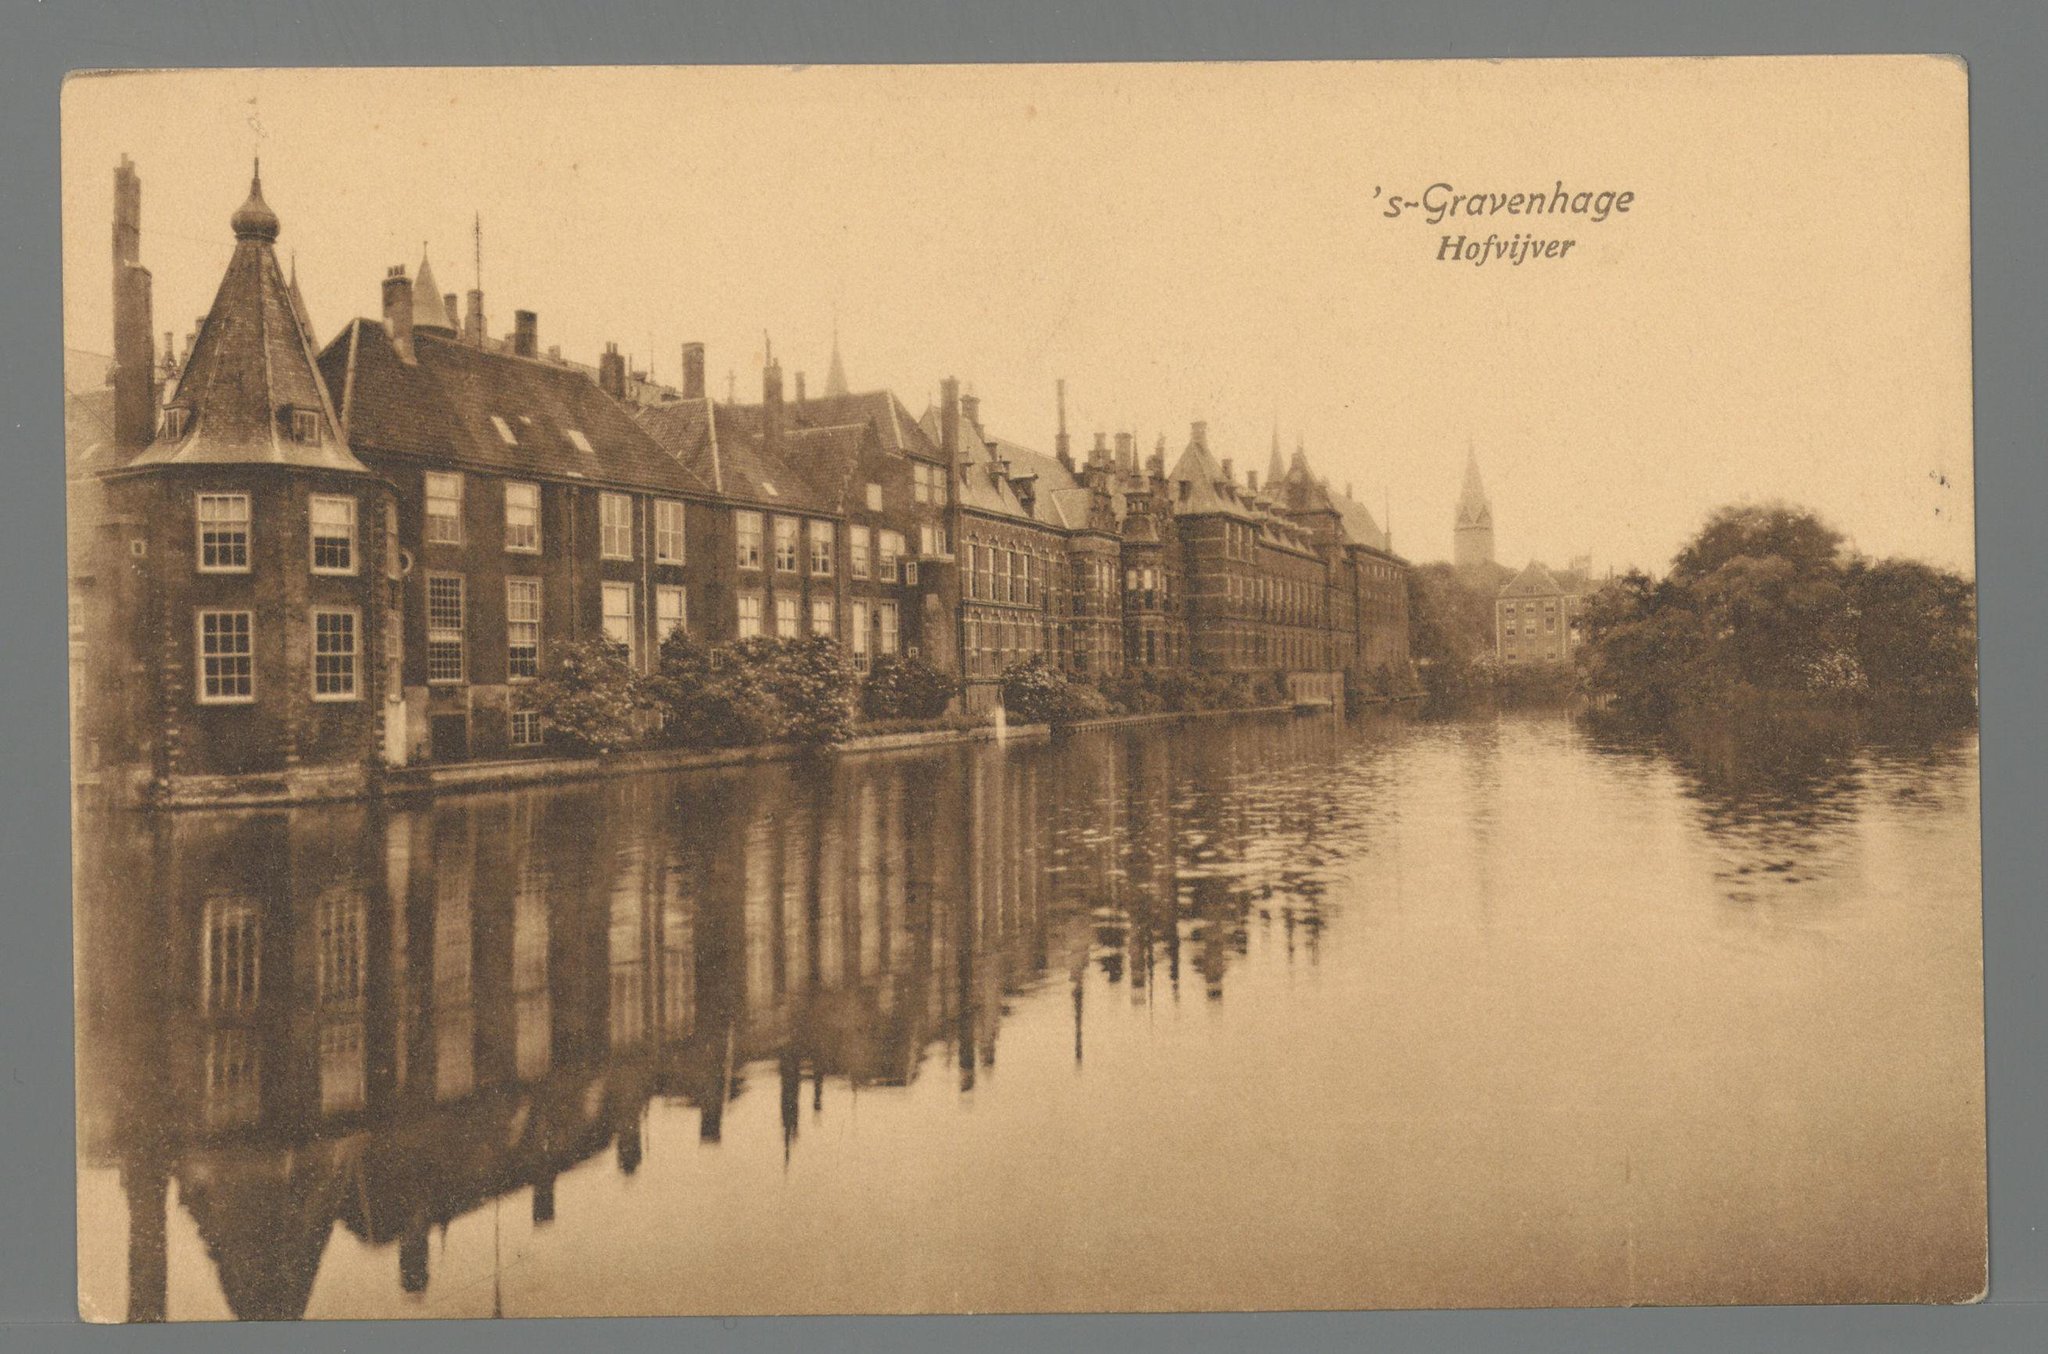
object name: photomechanical print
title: 's-Gravenhage. Hofvijver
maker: Anonymous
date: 1913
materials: cardboard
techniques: photograph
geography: the hague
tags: city-view, and landscape with man-made constructions, pond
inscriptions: date